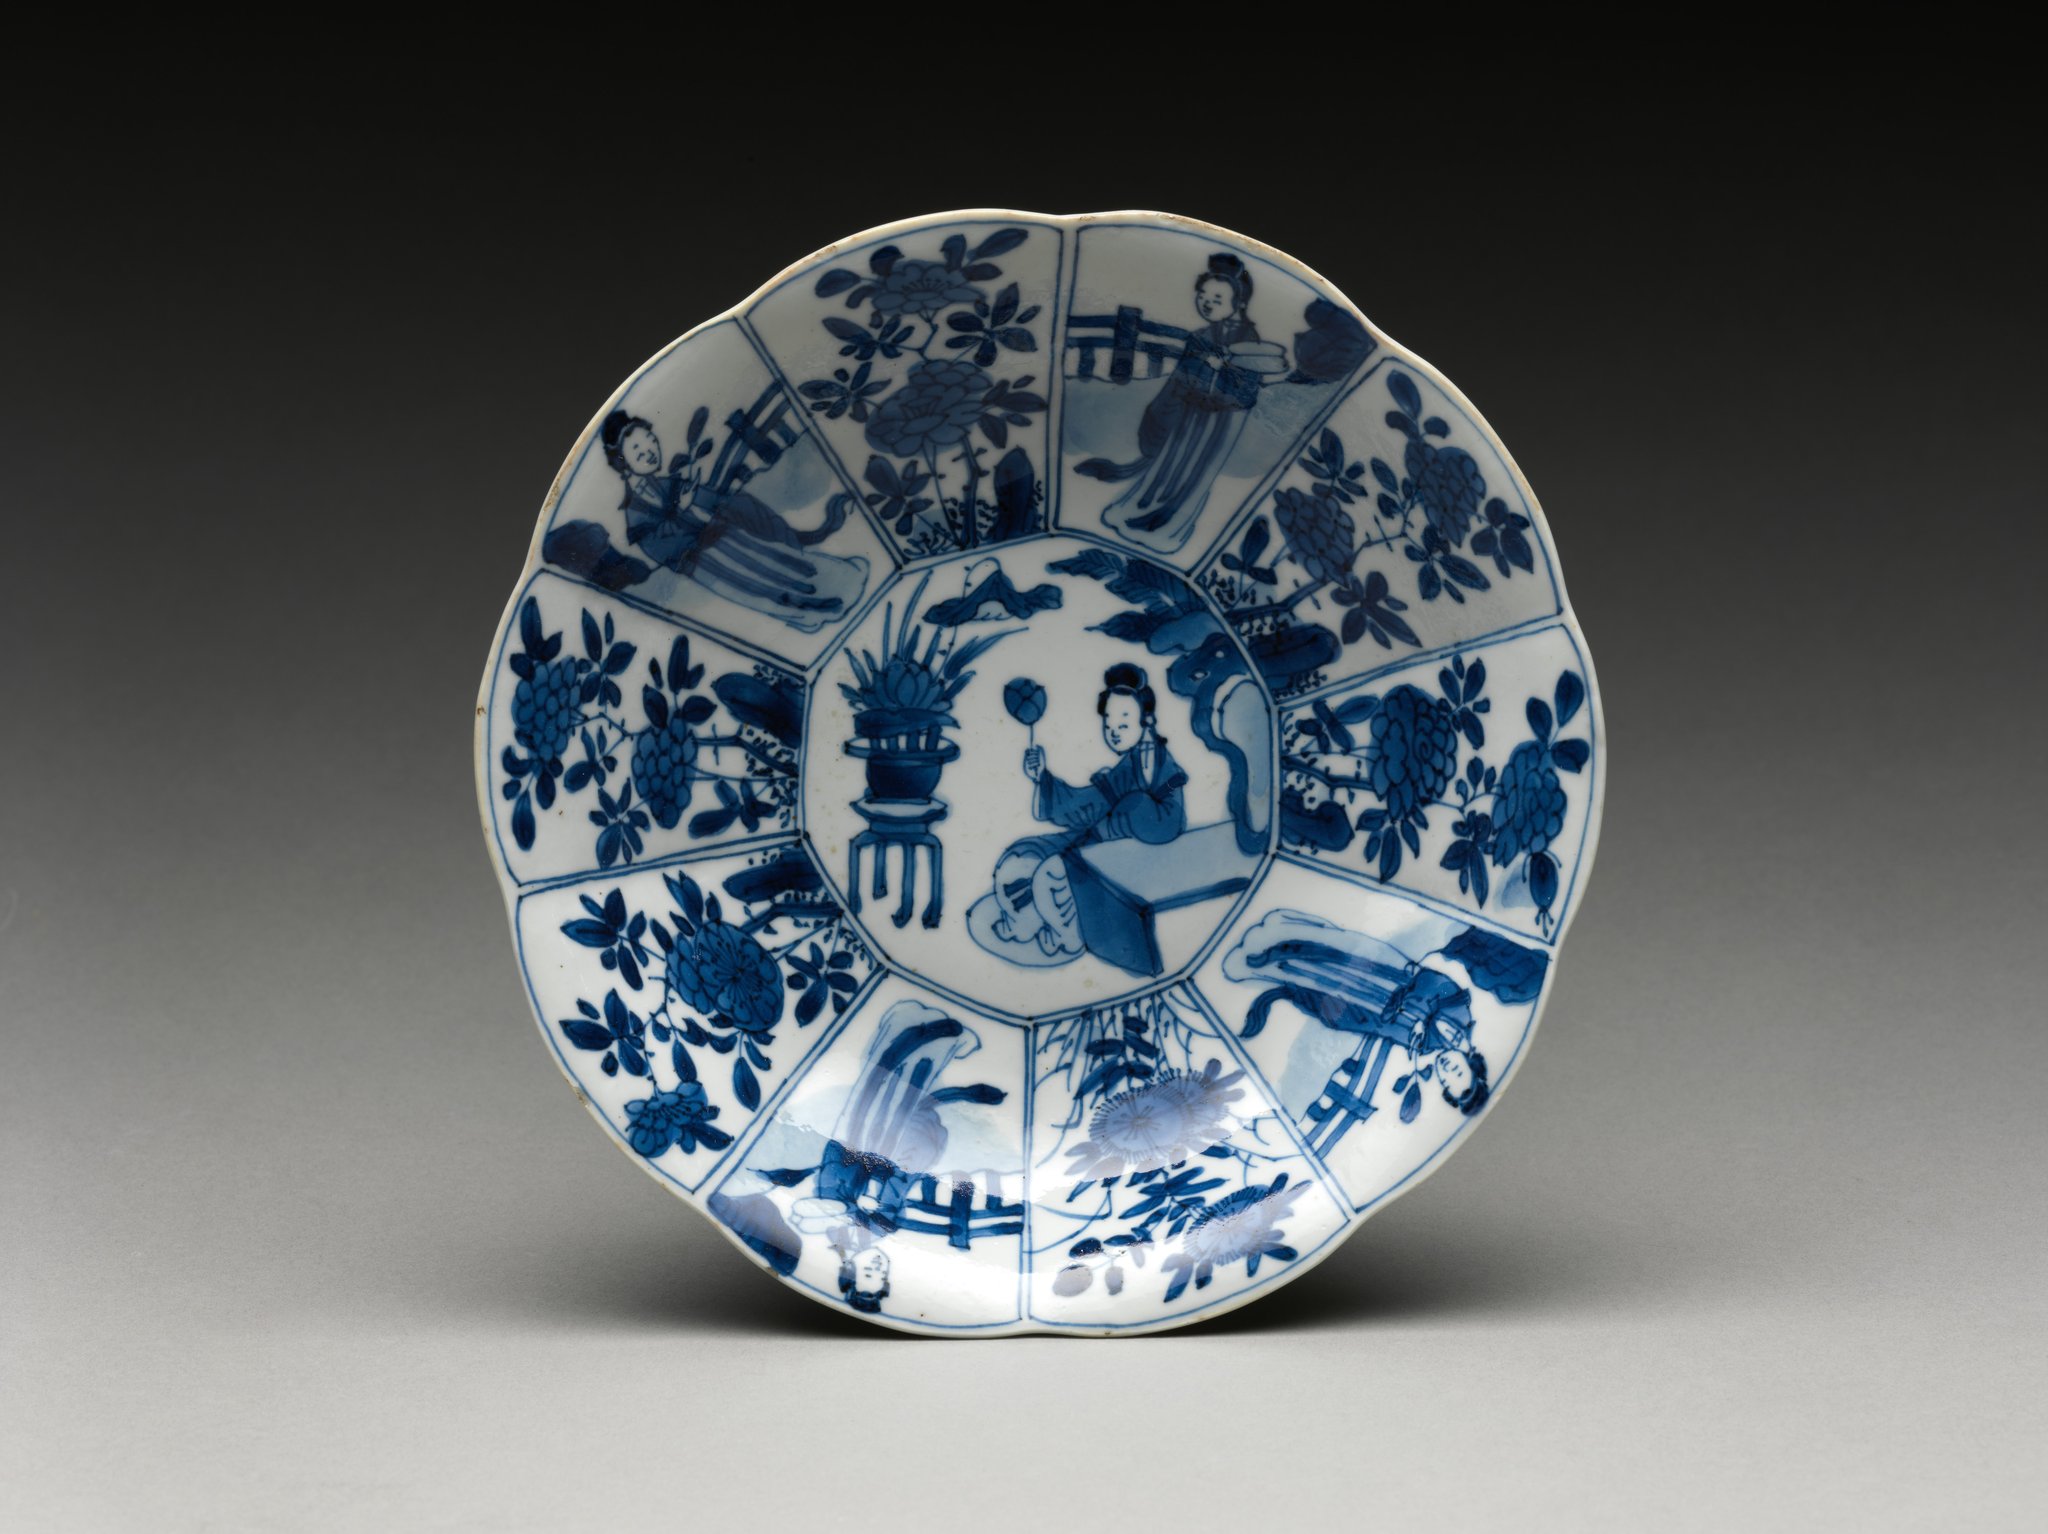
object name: plate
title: Plate with cartouches of women and plants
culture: chinese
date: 1662-1722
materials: cobalt, porcelain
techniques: painting, underglaze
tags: women,flowers